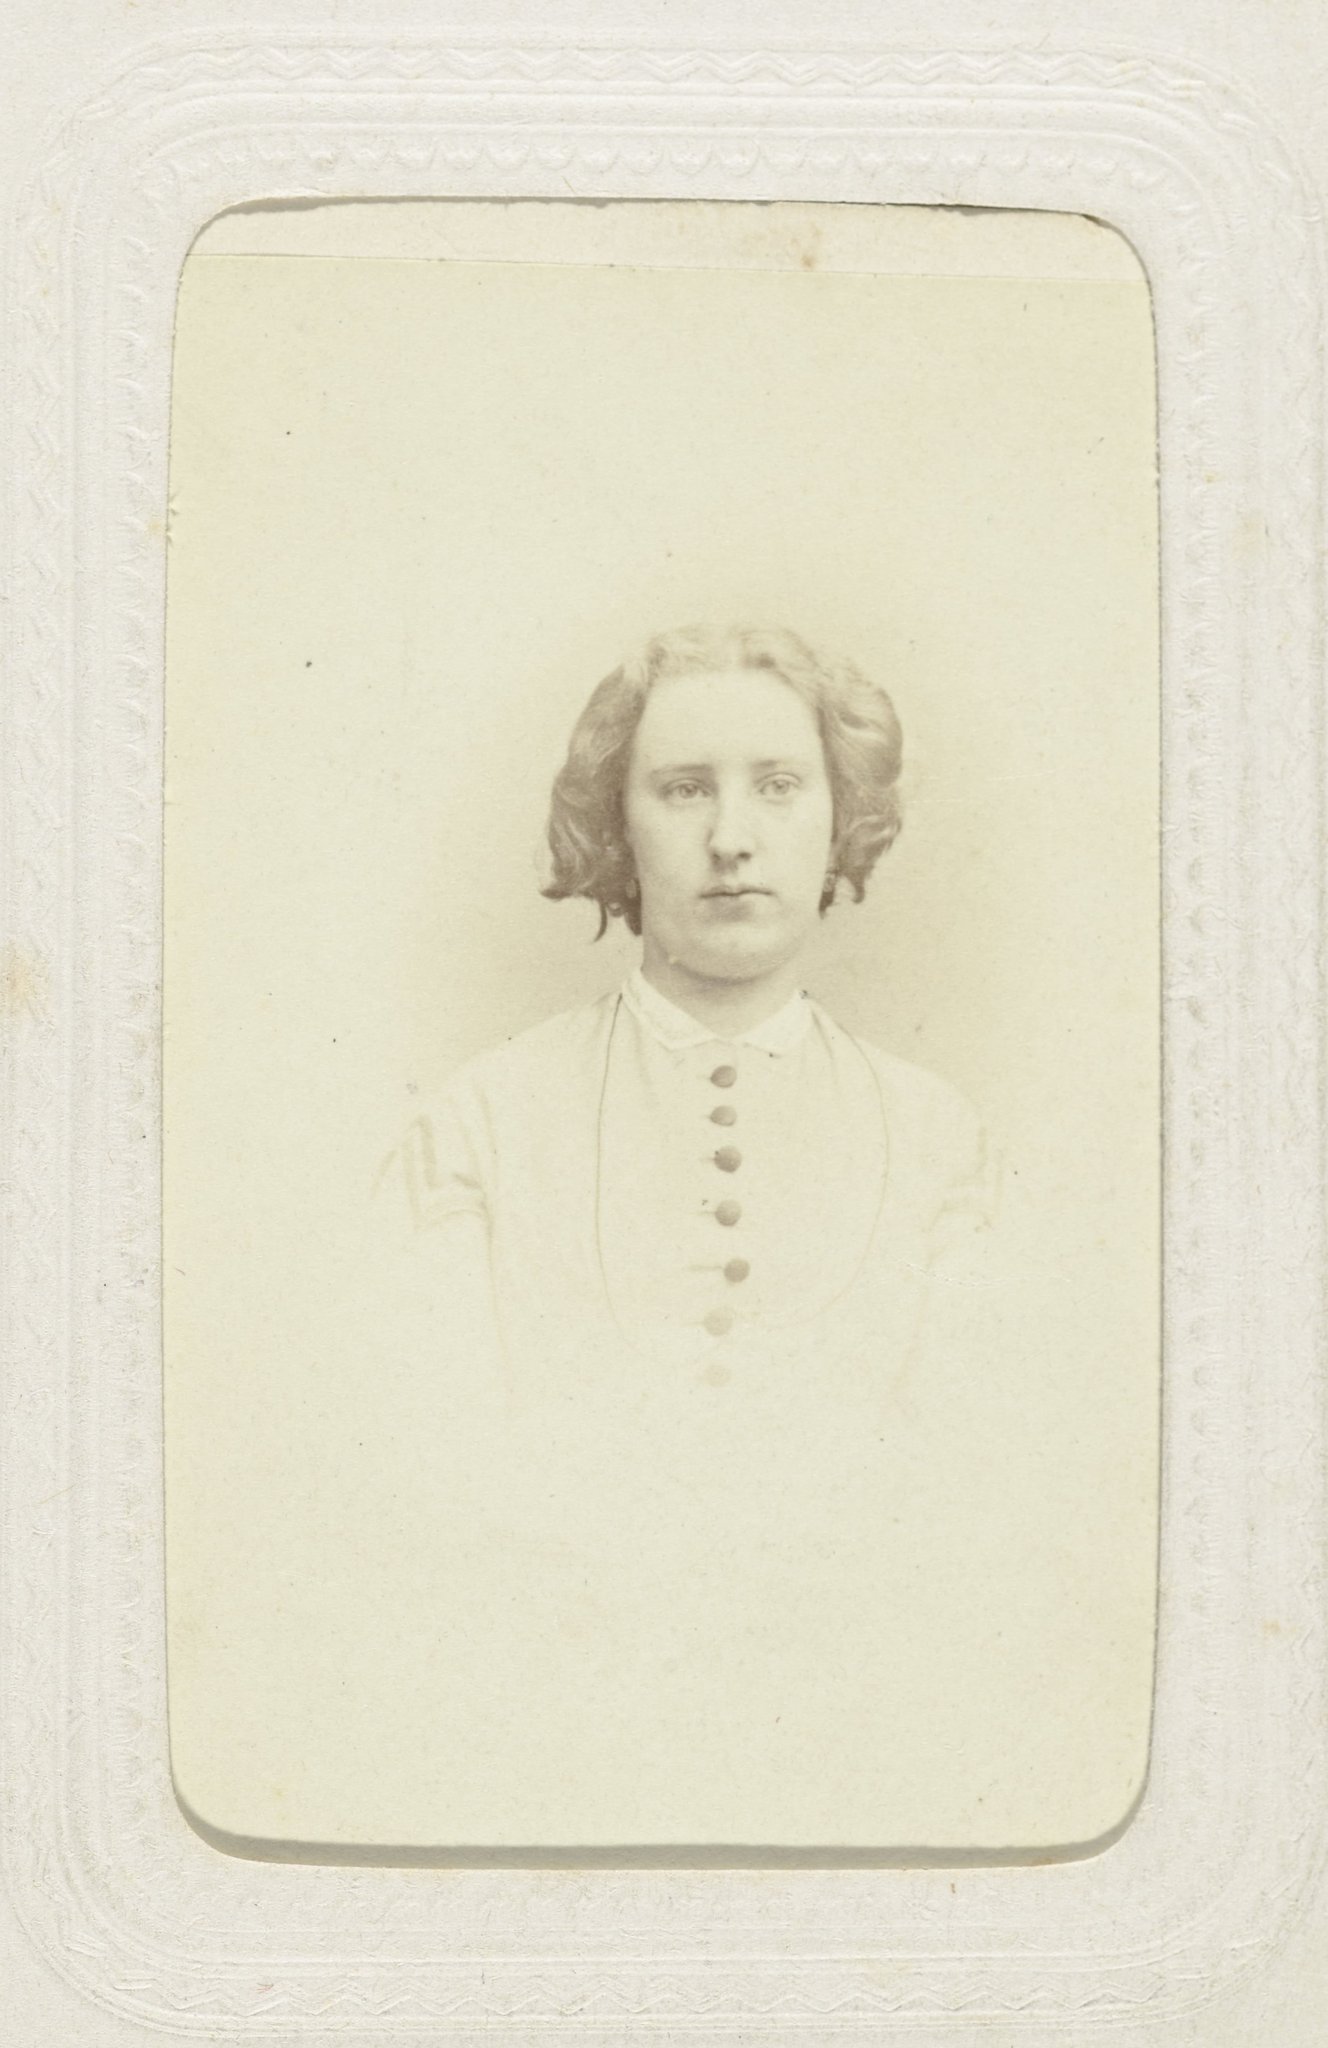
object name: carte de visite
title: Studioportret van een vrouw in een hooggesloten jurk en pijpenkrullen in het haar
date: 1863-1870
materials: cardboard, paper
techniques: albumen print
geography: amsterdam